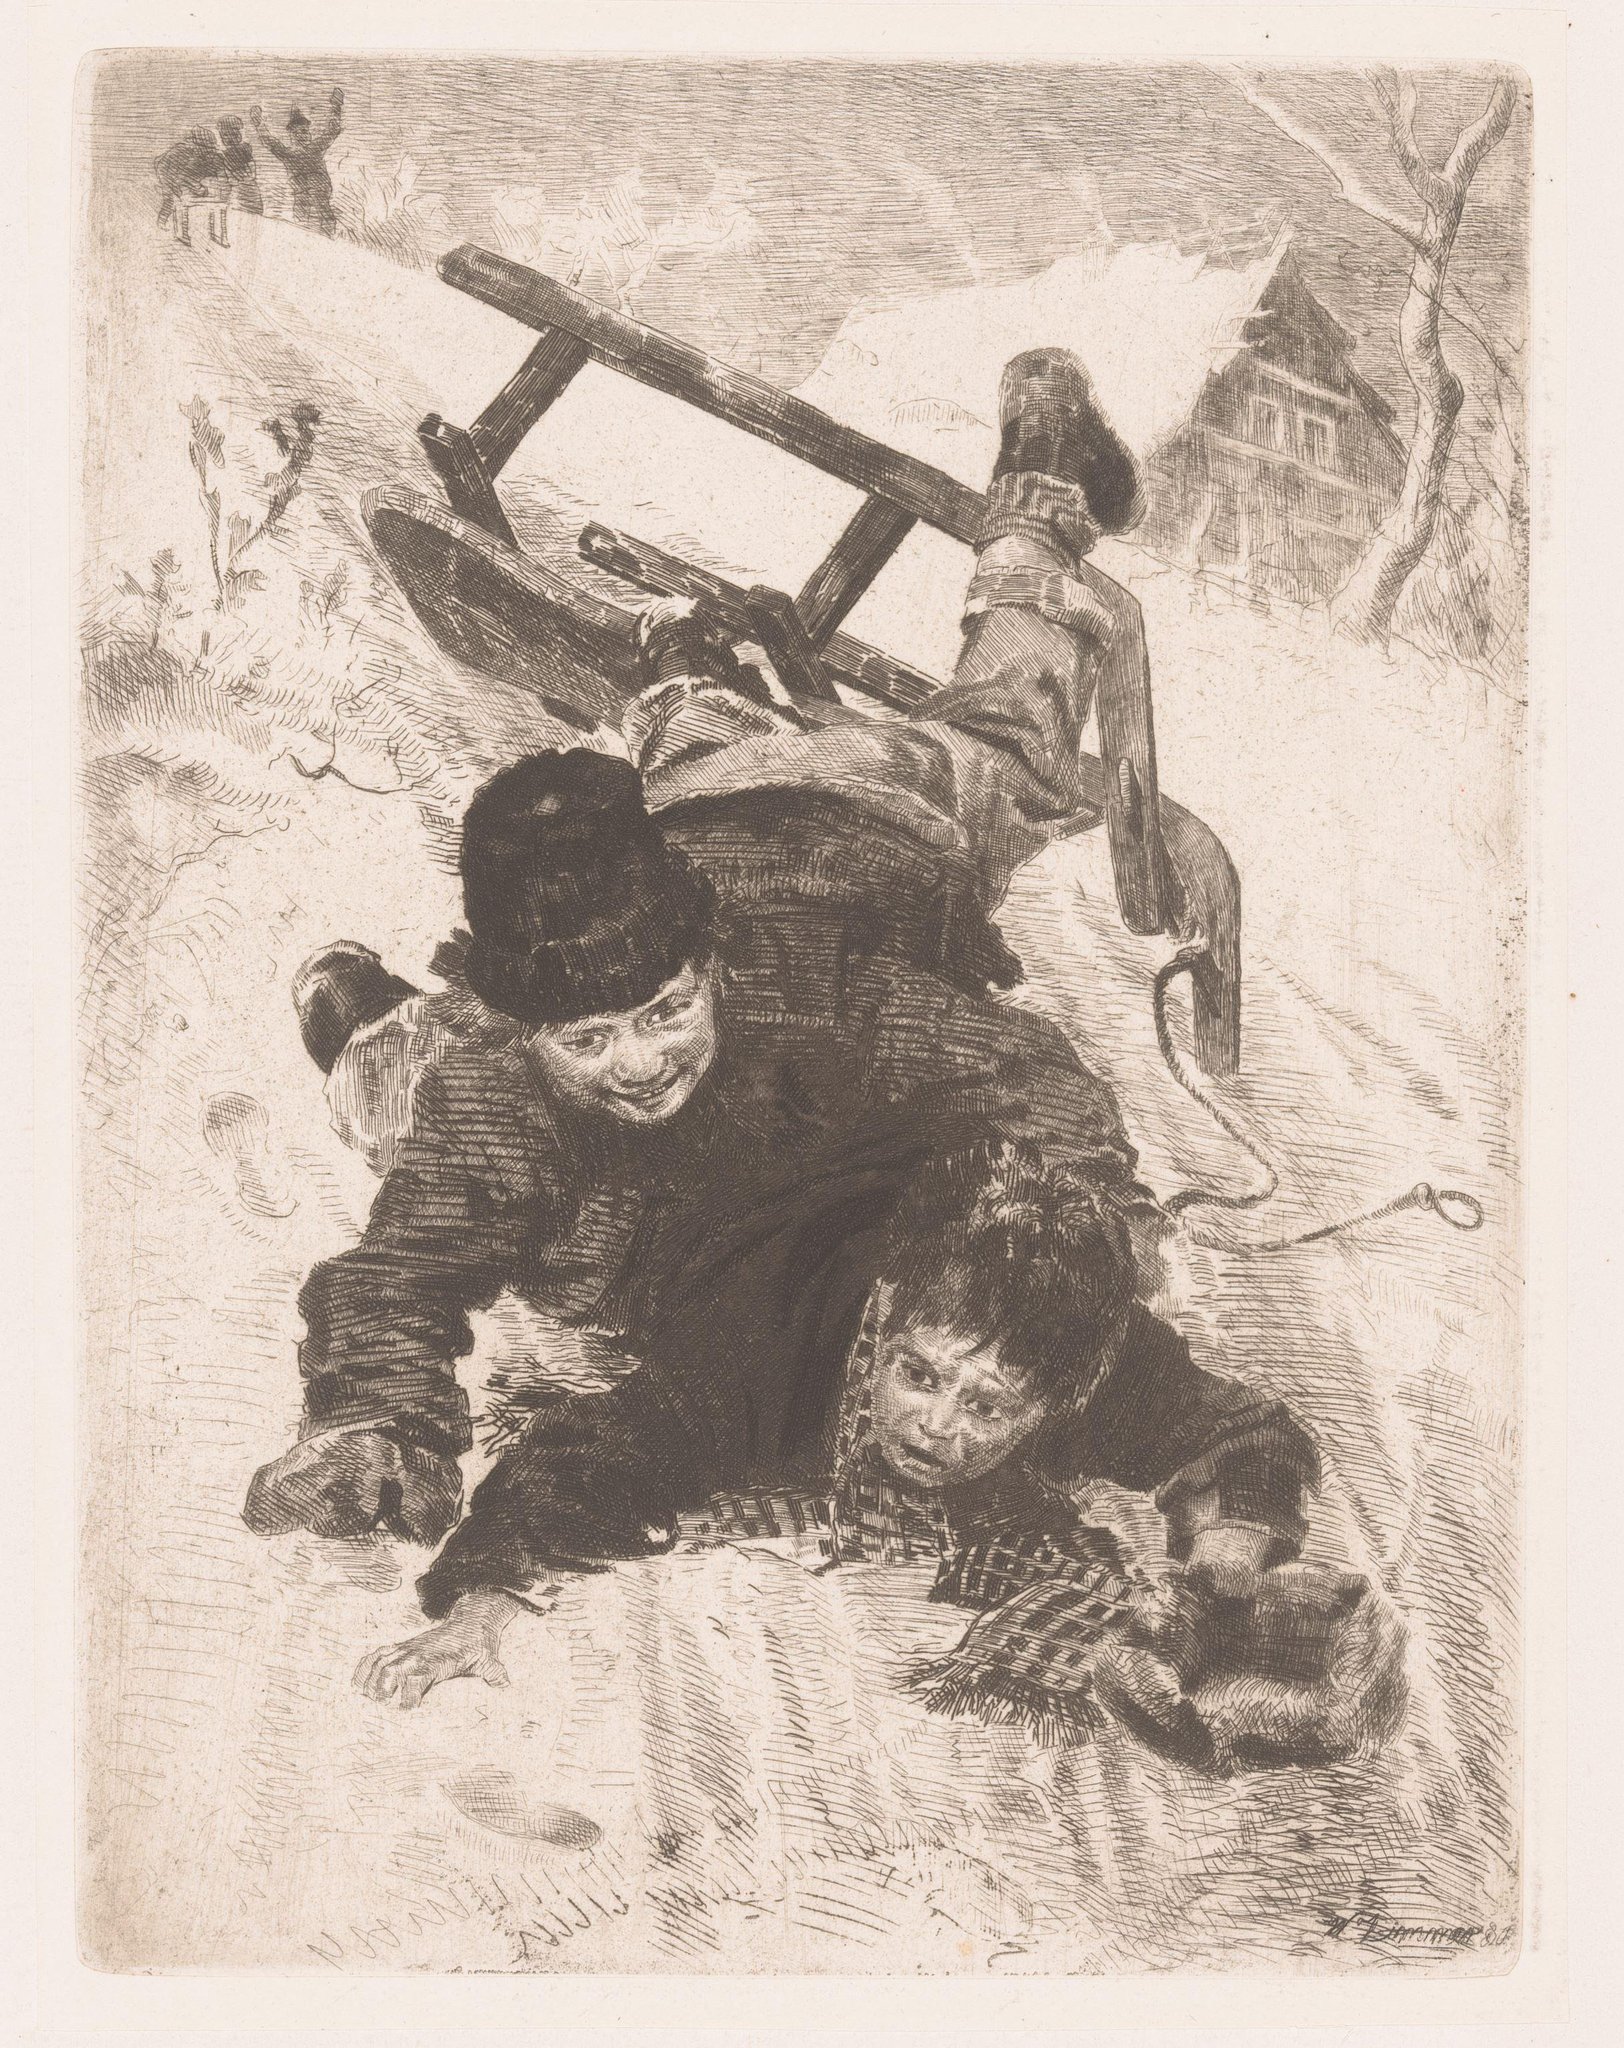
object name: print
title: Twee jongens vallen van een slede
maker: wilhelm carl august zimmer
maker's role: print maker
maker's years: 1853-1937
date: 1887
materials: paper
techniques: etching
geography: germany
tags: boy (child between toddler and youth), sleigh, sledge (non-sport), snow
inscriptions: collector's mark: Lugt 2228